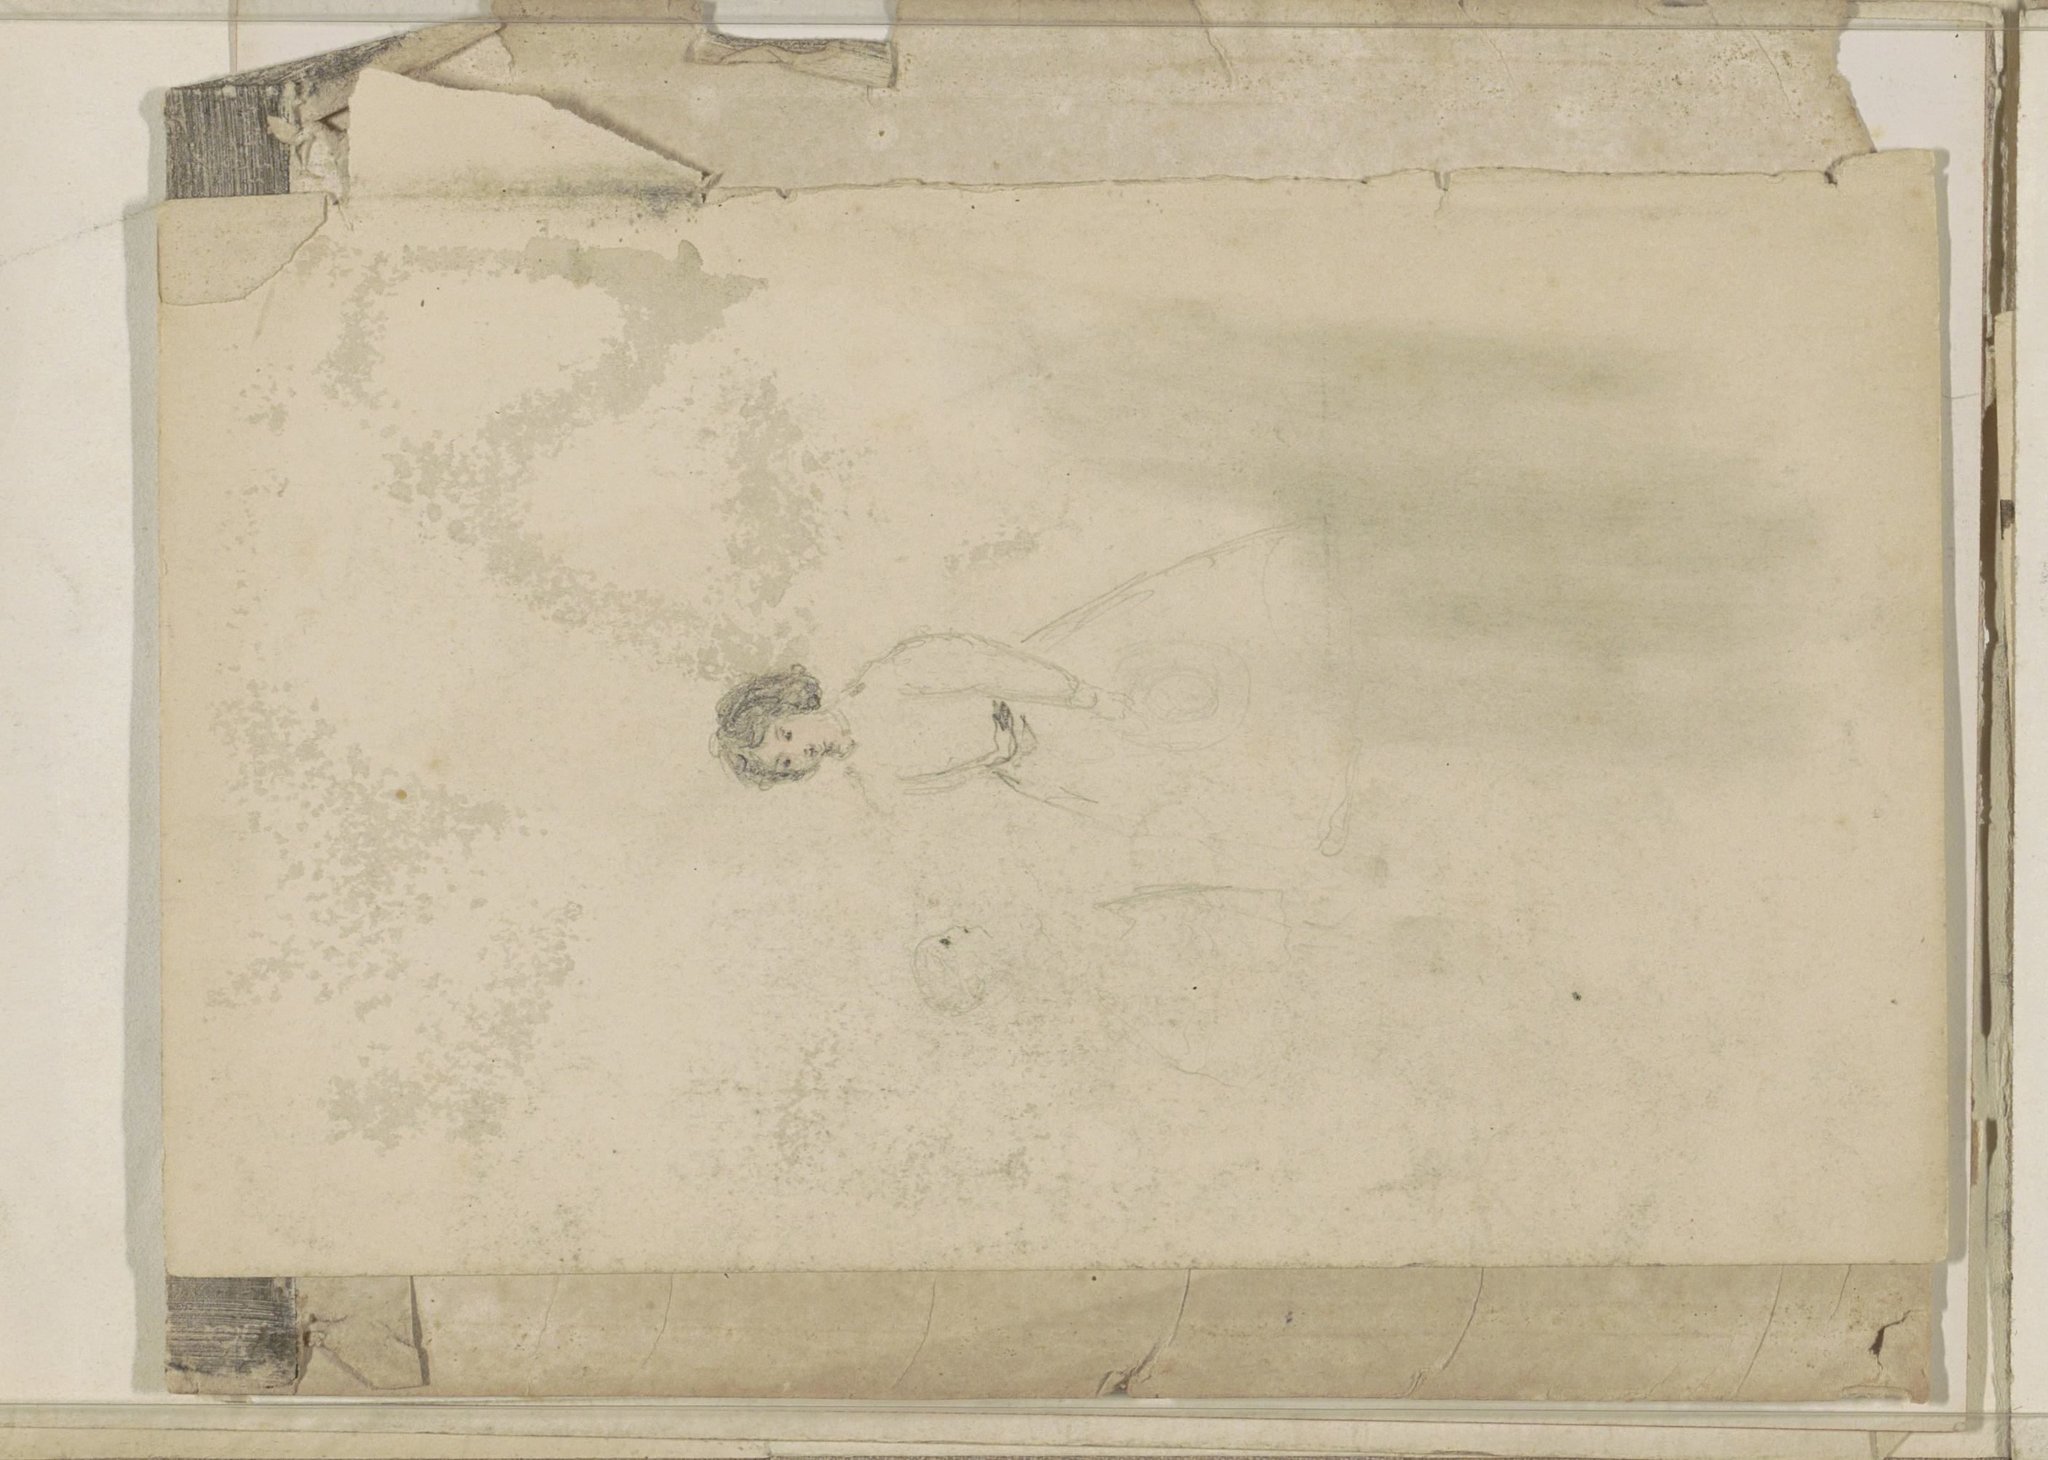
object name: sketchbook leaf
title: Jonge vrouw met een hoed in de hand naast een meisje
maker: a.a.l. de grammont-hubrecht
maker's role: draughtsman, painter, print maker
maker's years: 1855-1913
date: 1865-1913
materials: paper, pencil, watercolor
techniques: brush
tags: adult woman, head-gear: hat (+ women's clothes), girl (child between toddler and youth)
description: Verso-zijde van een losse schets tussen pagina 1 en 2 uit een schetsboek met 68 bladen.